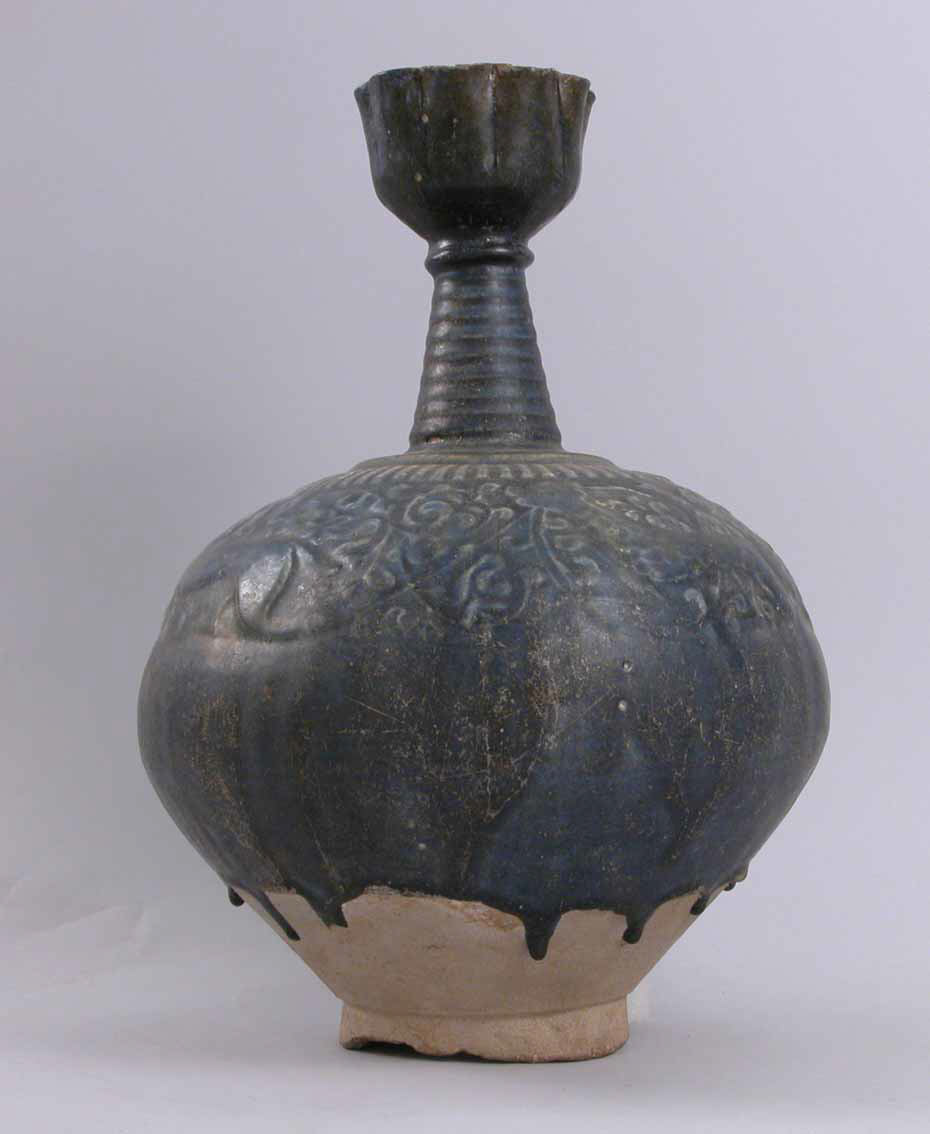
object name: bottle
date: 1067-1133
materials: paste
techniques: carving, glazing, molding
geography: iran